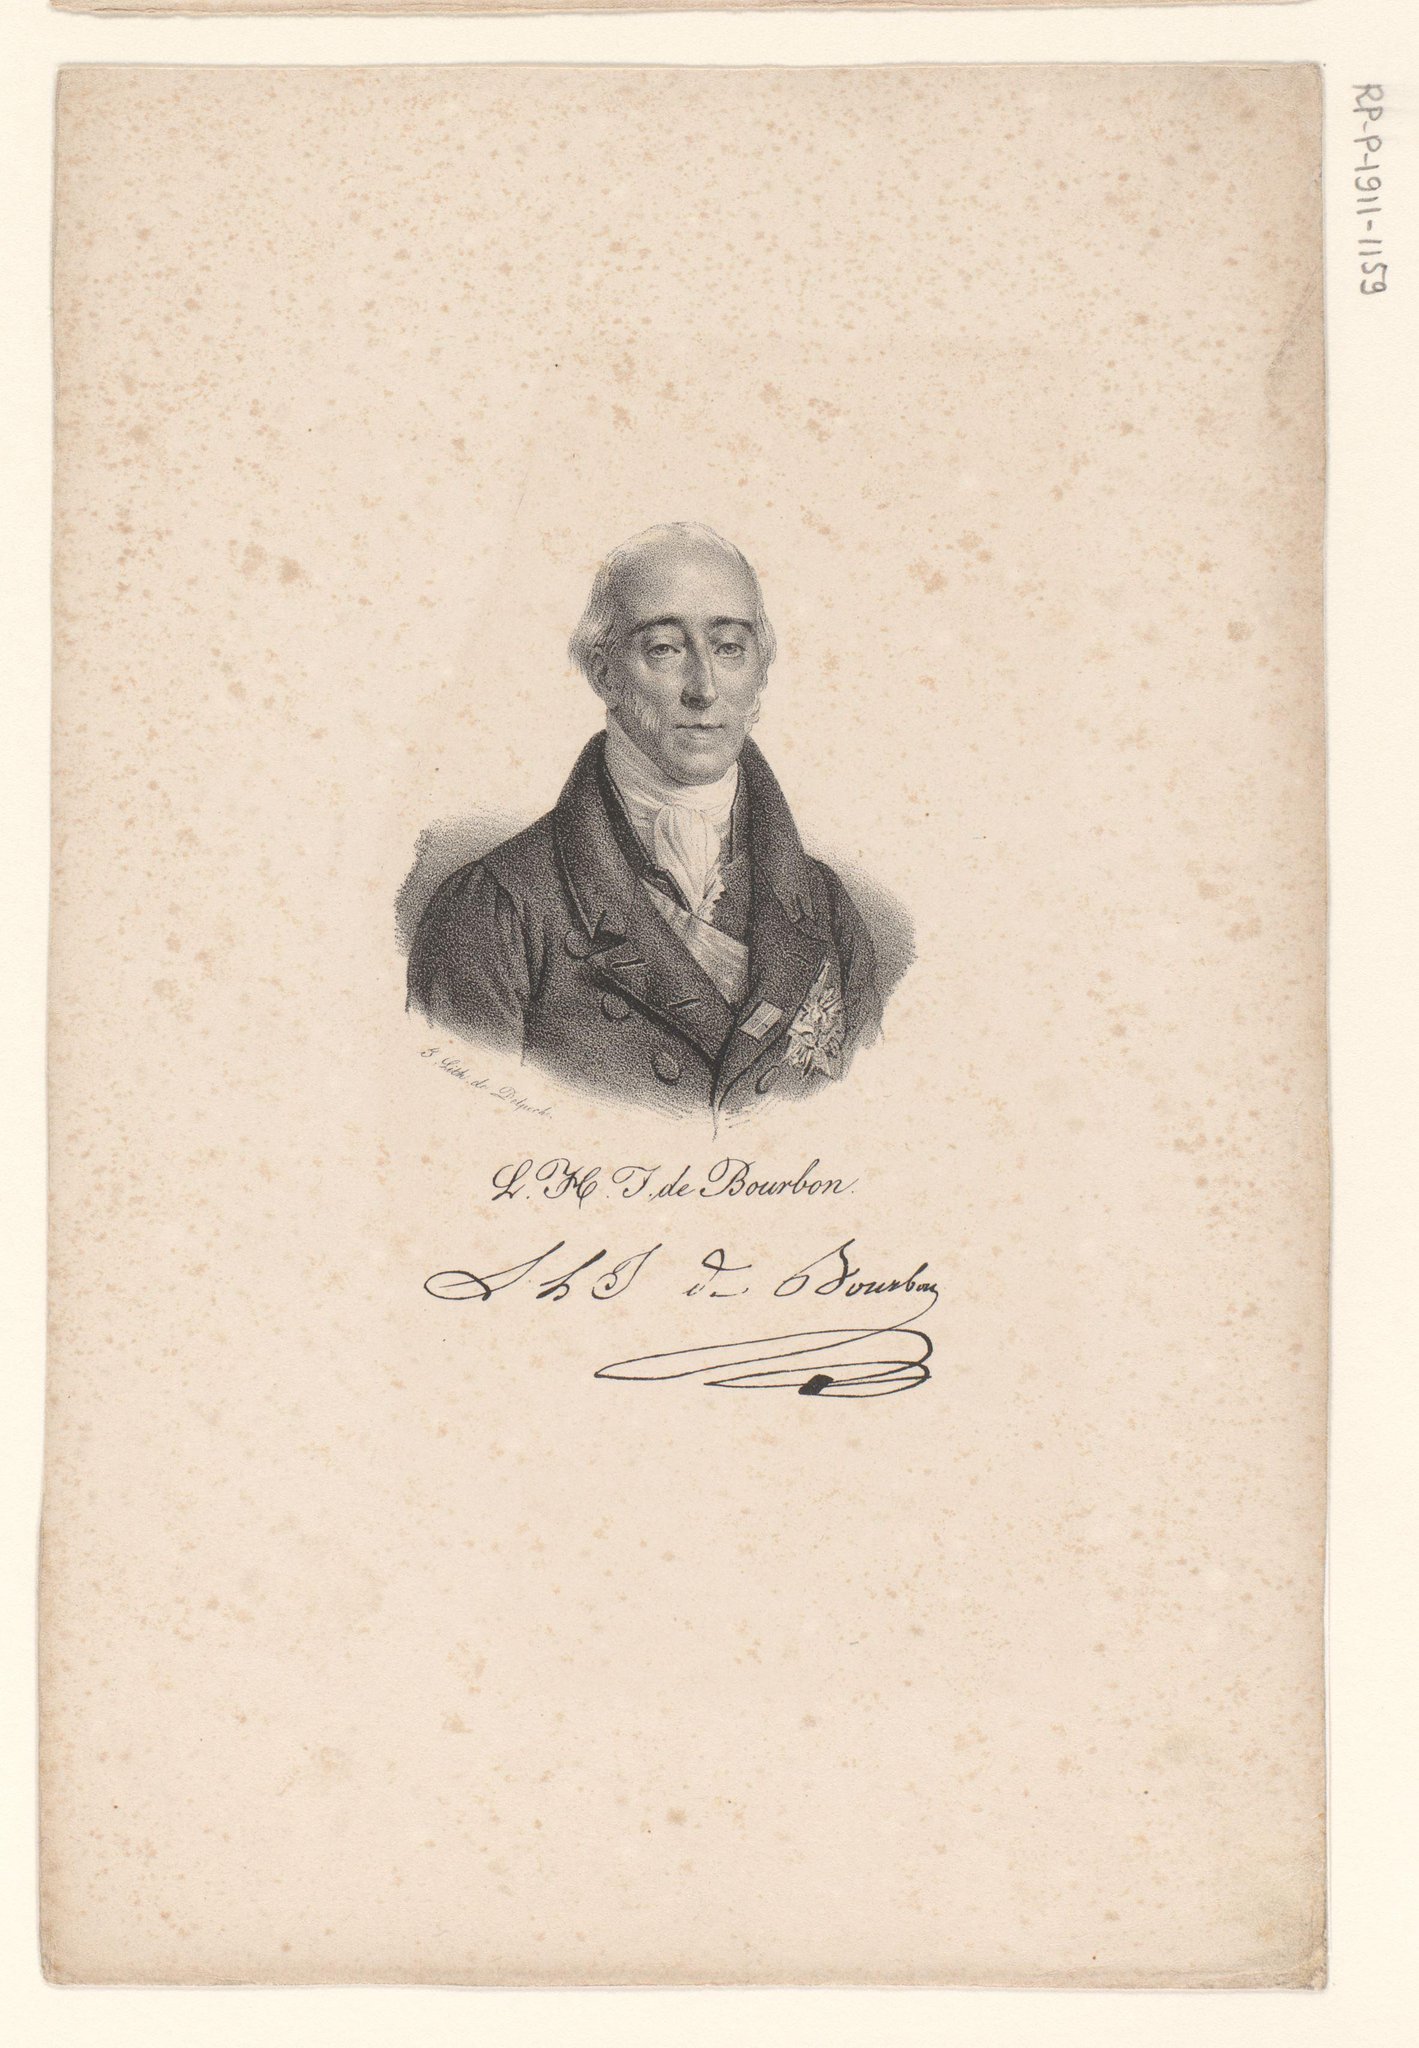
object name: print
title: Portret van Portret van Lodewijk VI de Bourbon-Condé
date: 1818-1842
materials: paper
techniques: lithograph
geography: paris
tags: historical persons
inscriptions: collector's mark: Lugt 2228a